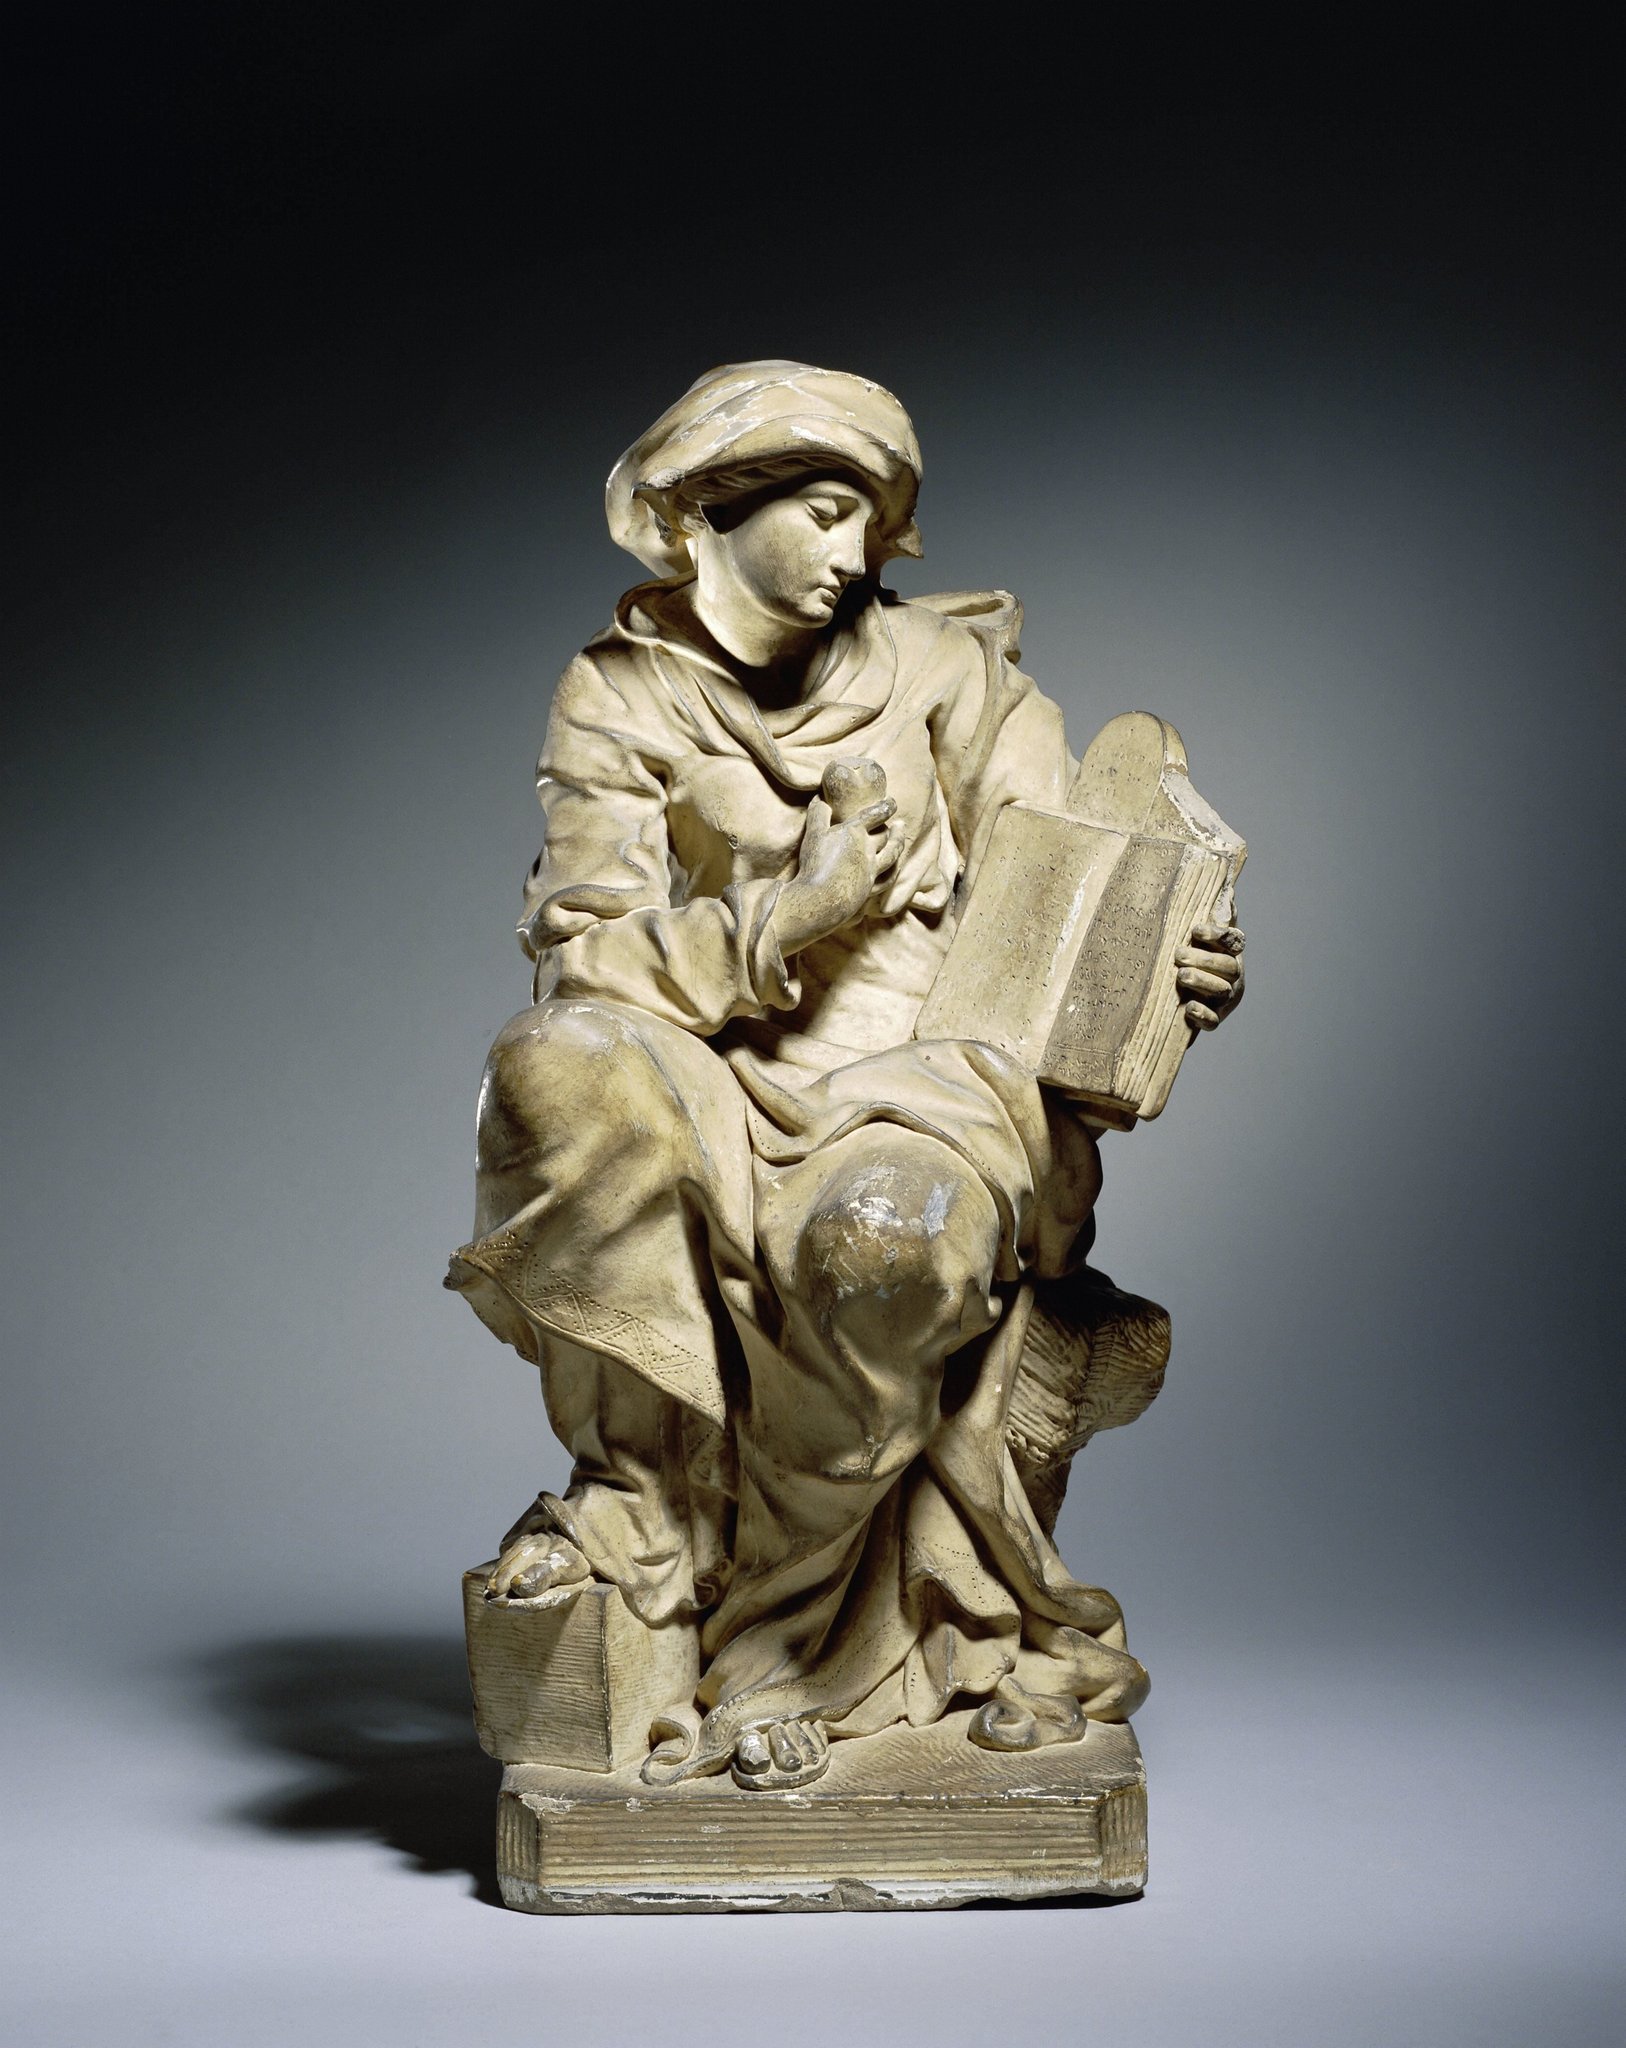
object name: sculpture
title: Geloof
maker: willem hendrik van der wall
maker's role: sculptor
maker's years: 1716-1790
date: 1775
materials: terracotta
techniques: modeling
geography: utrecht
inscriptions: signature and date: ‘WH. V.D. WALL 1775’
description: Willem Hendrik van de Wall (1716 - 1790). Faith, Hope and Charity. Terracotta. Utrecht, 1775 and 1776.